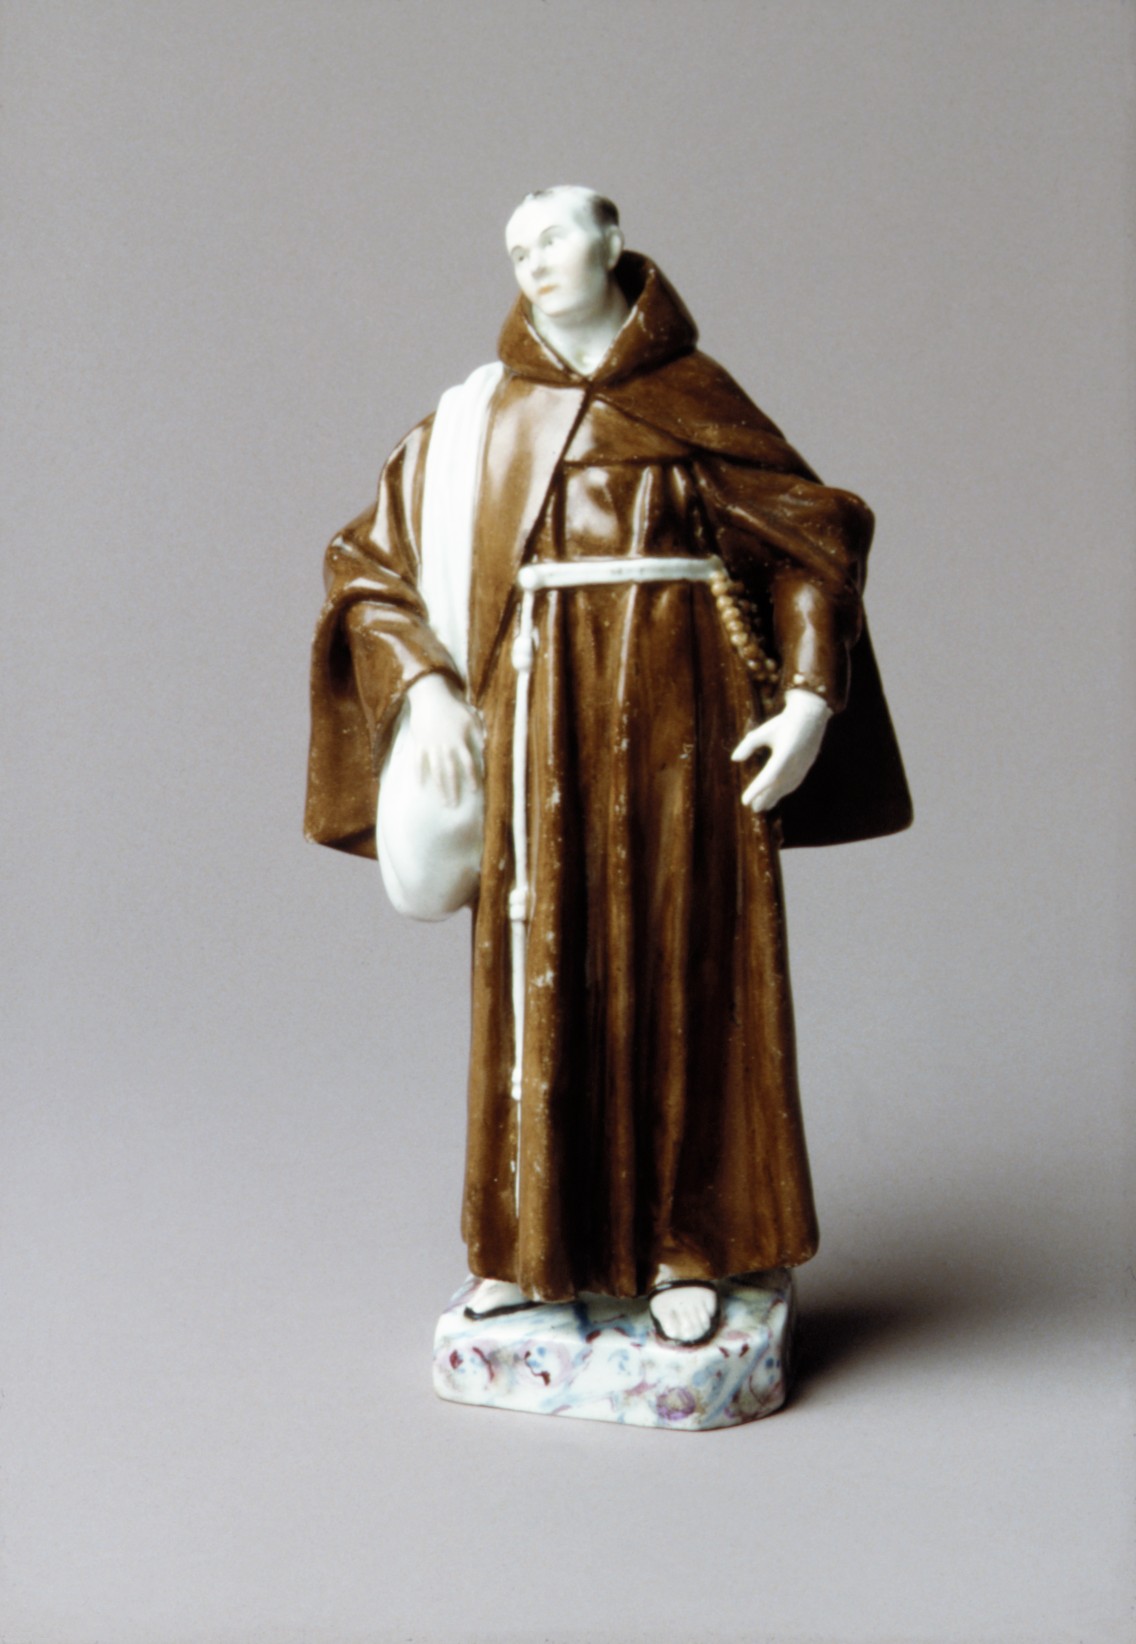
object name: figure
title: Mendicant Capuchin Friar (one of a pair)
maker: höchst manufactory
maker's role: manufactory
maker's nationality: german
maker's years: 1746-1796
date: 1765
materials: hard paste porcelain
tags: men